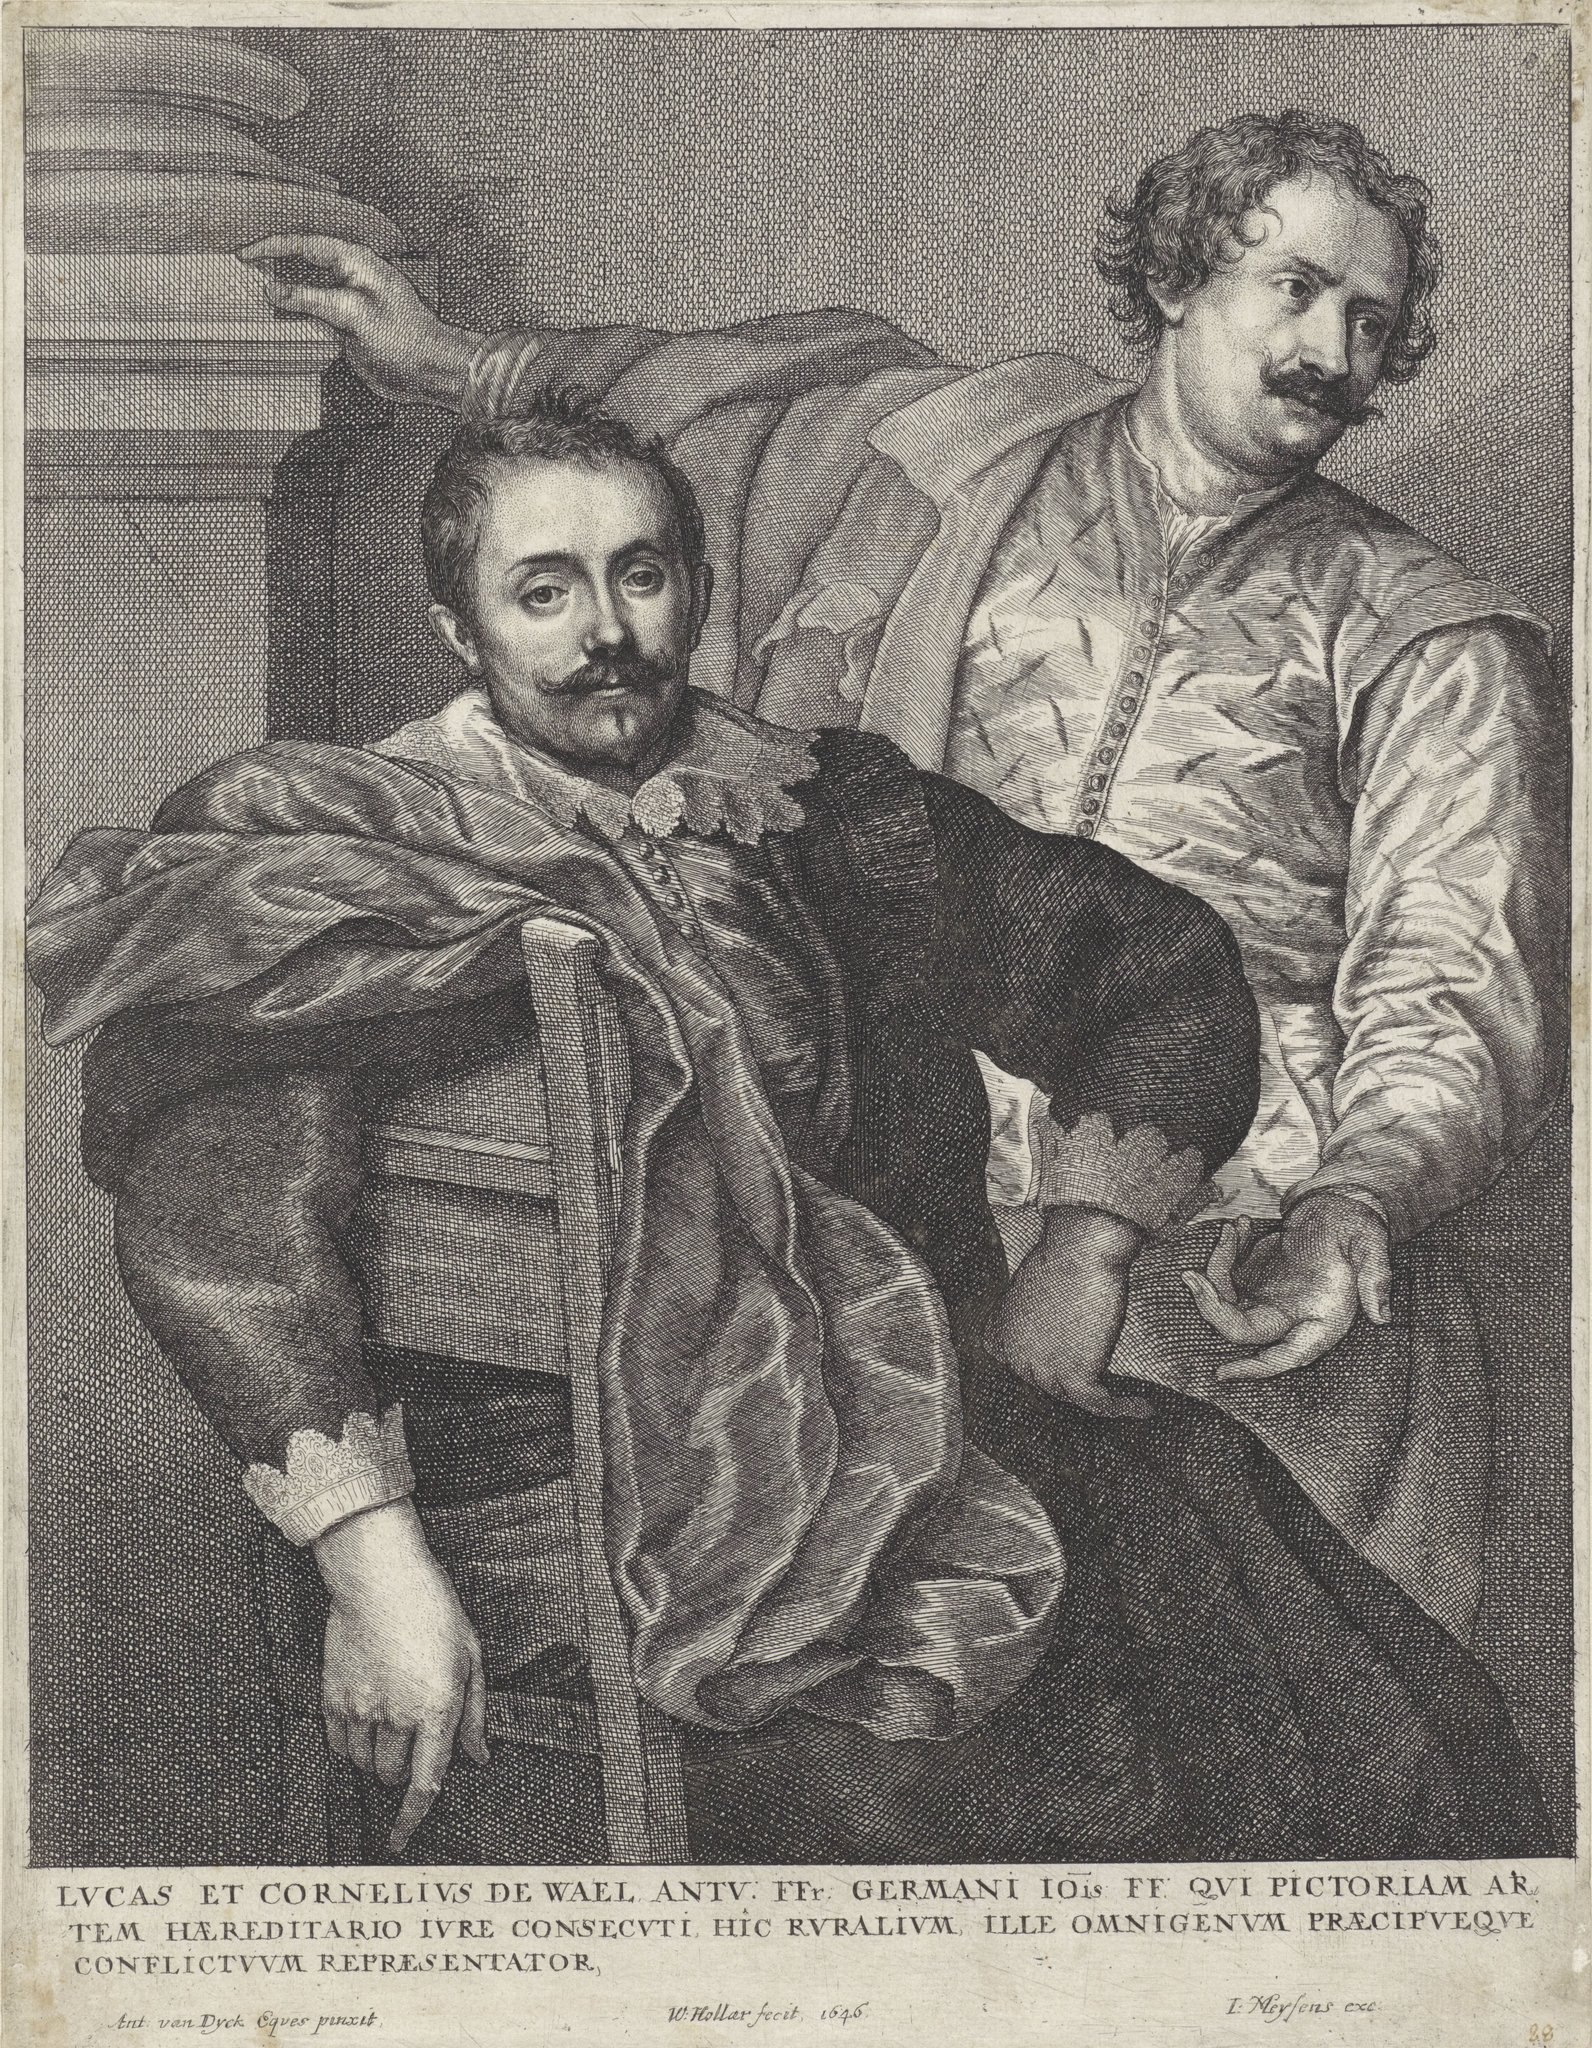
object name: print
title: Portretten naar Anthony van Dyck door Joannes Meyssens uitgegeven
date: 1646-1670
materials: paper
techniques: etching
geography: antwerp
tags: antwerp, rome, print maker, draughtsman, cornelis de wael, historical persons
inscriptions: collector's mark: Lugt 240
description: De prent maakt deel uit van een zevendelige serie portretten naar Anthony van Dyck, uitgegeven door Joannes Meyssens.